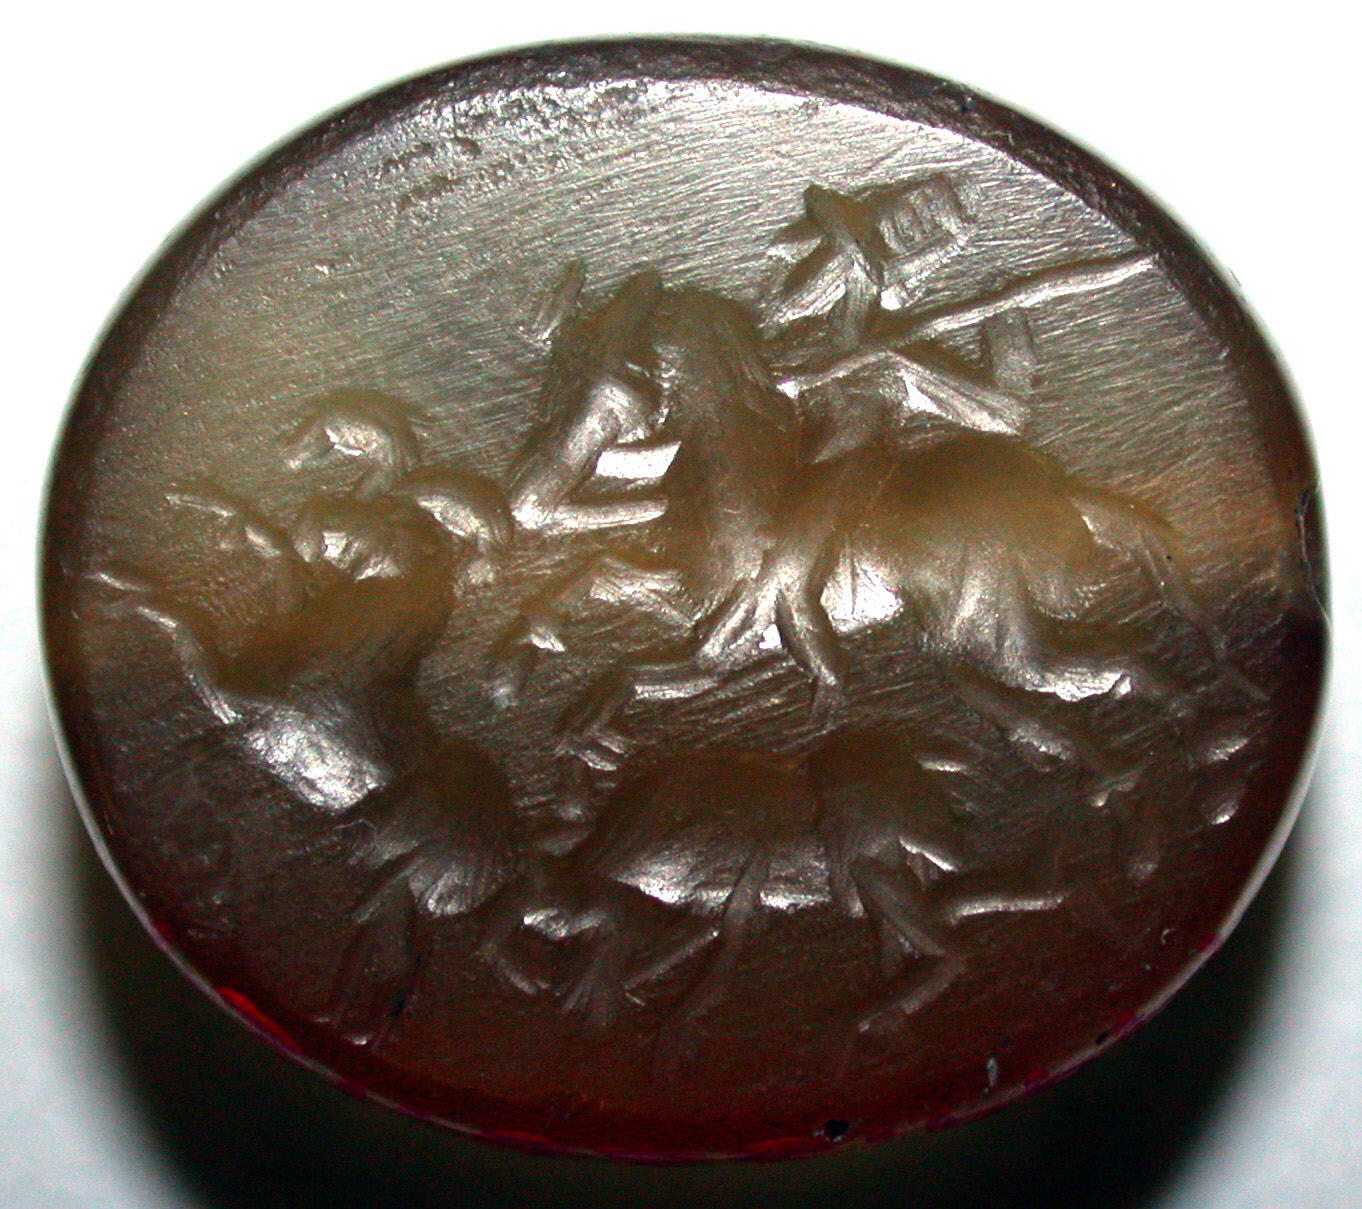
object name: stamp seal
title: Stamp seal and modern impression: hunter on horse attacking rams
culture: graeco-bactrian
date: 300-1 BCE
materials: stone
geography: iran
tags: hunting,horses,rams